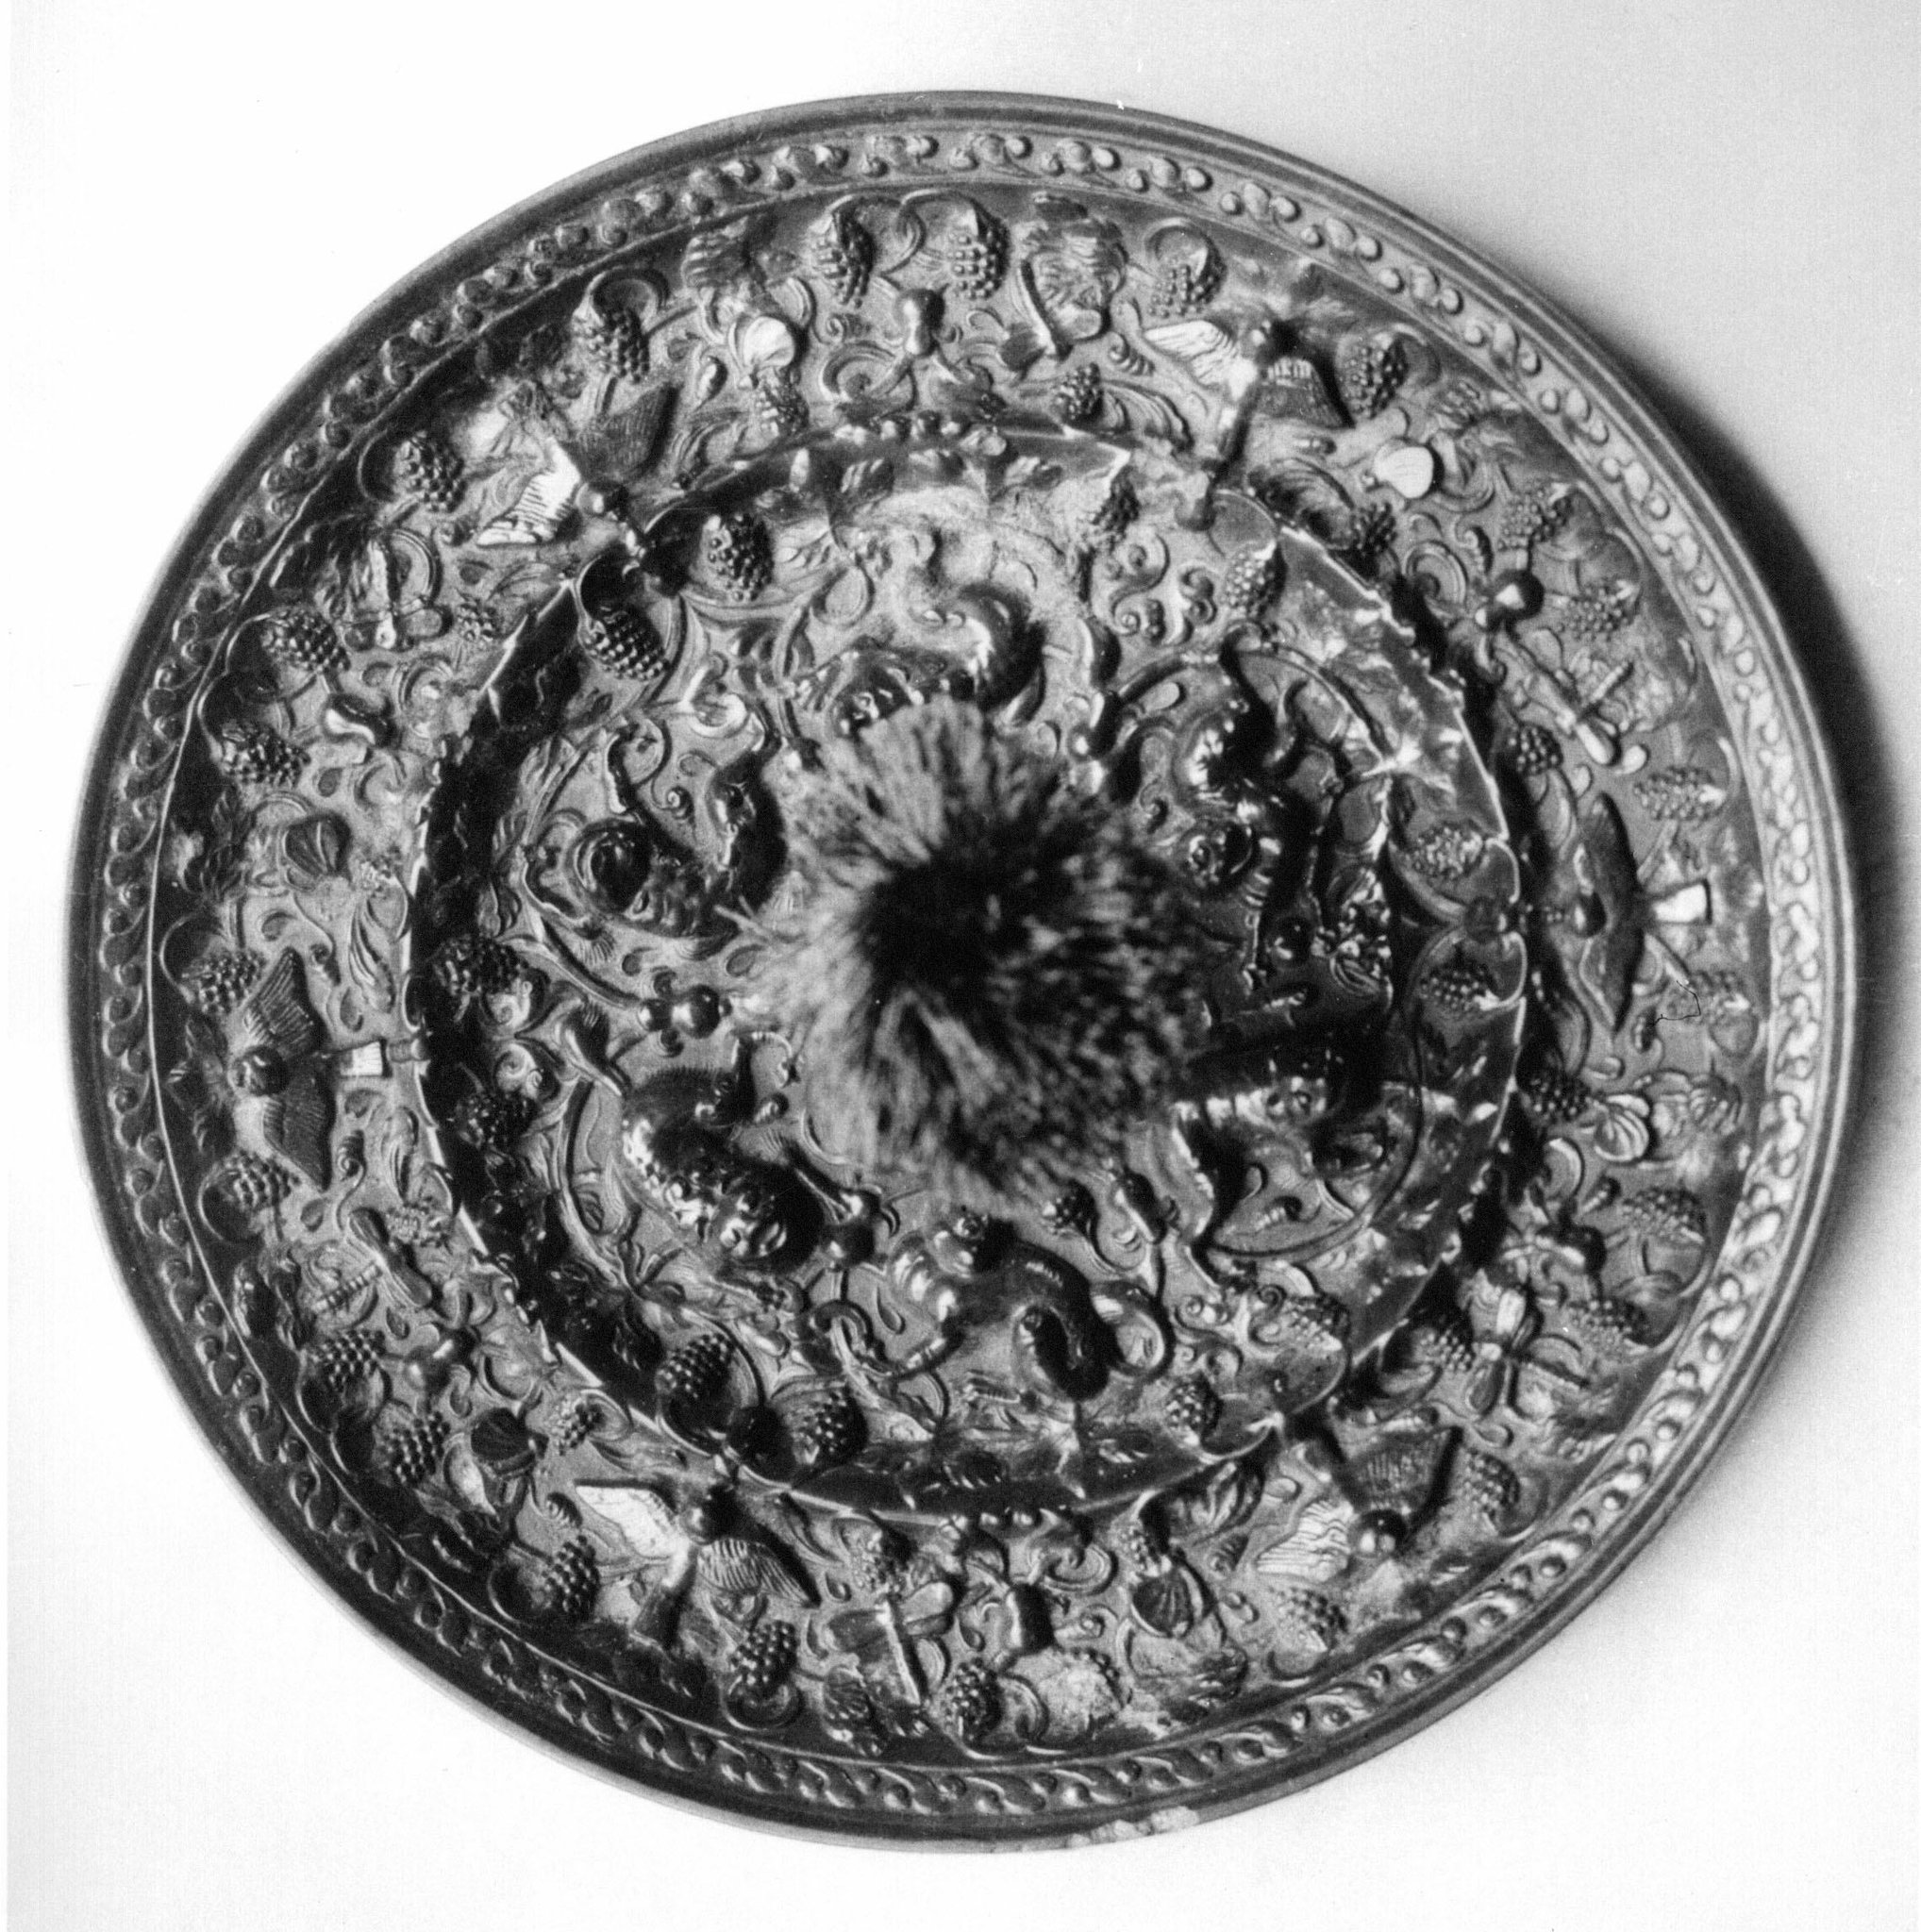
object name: mirror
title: Mirror with birds and beasts amid grape vines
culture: chinese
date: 601-800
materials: bronze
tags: animals,grapes